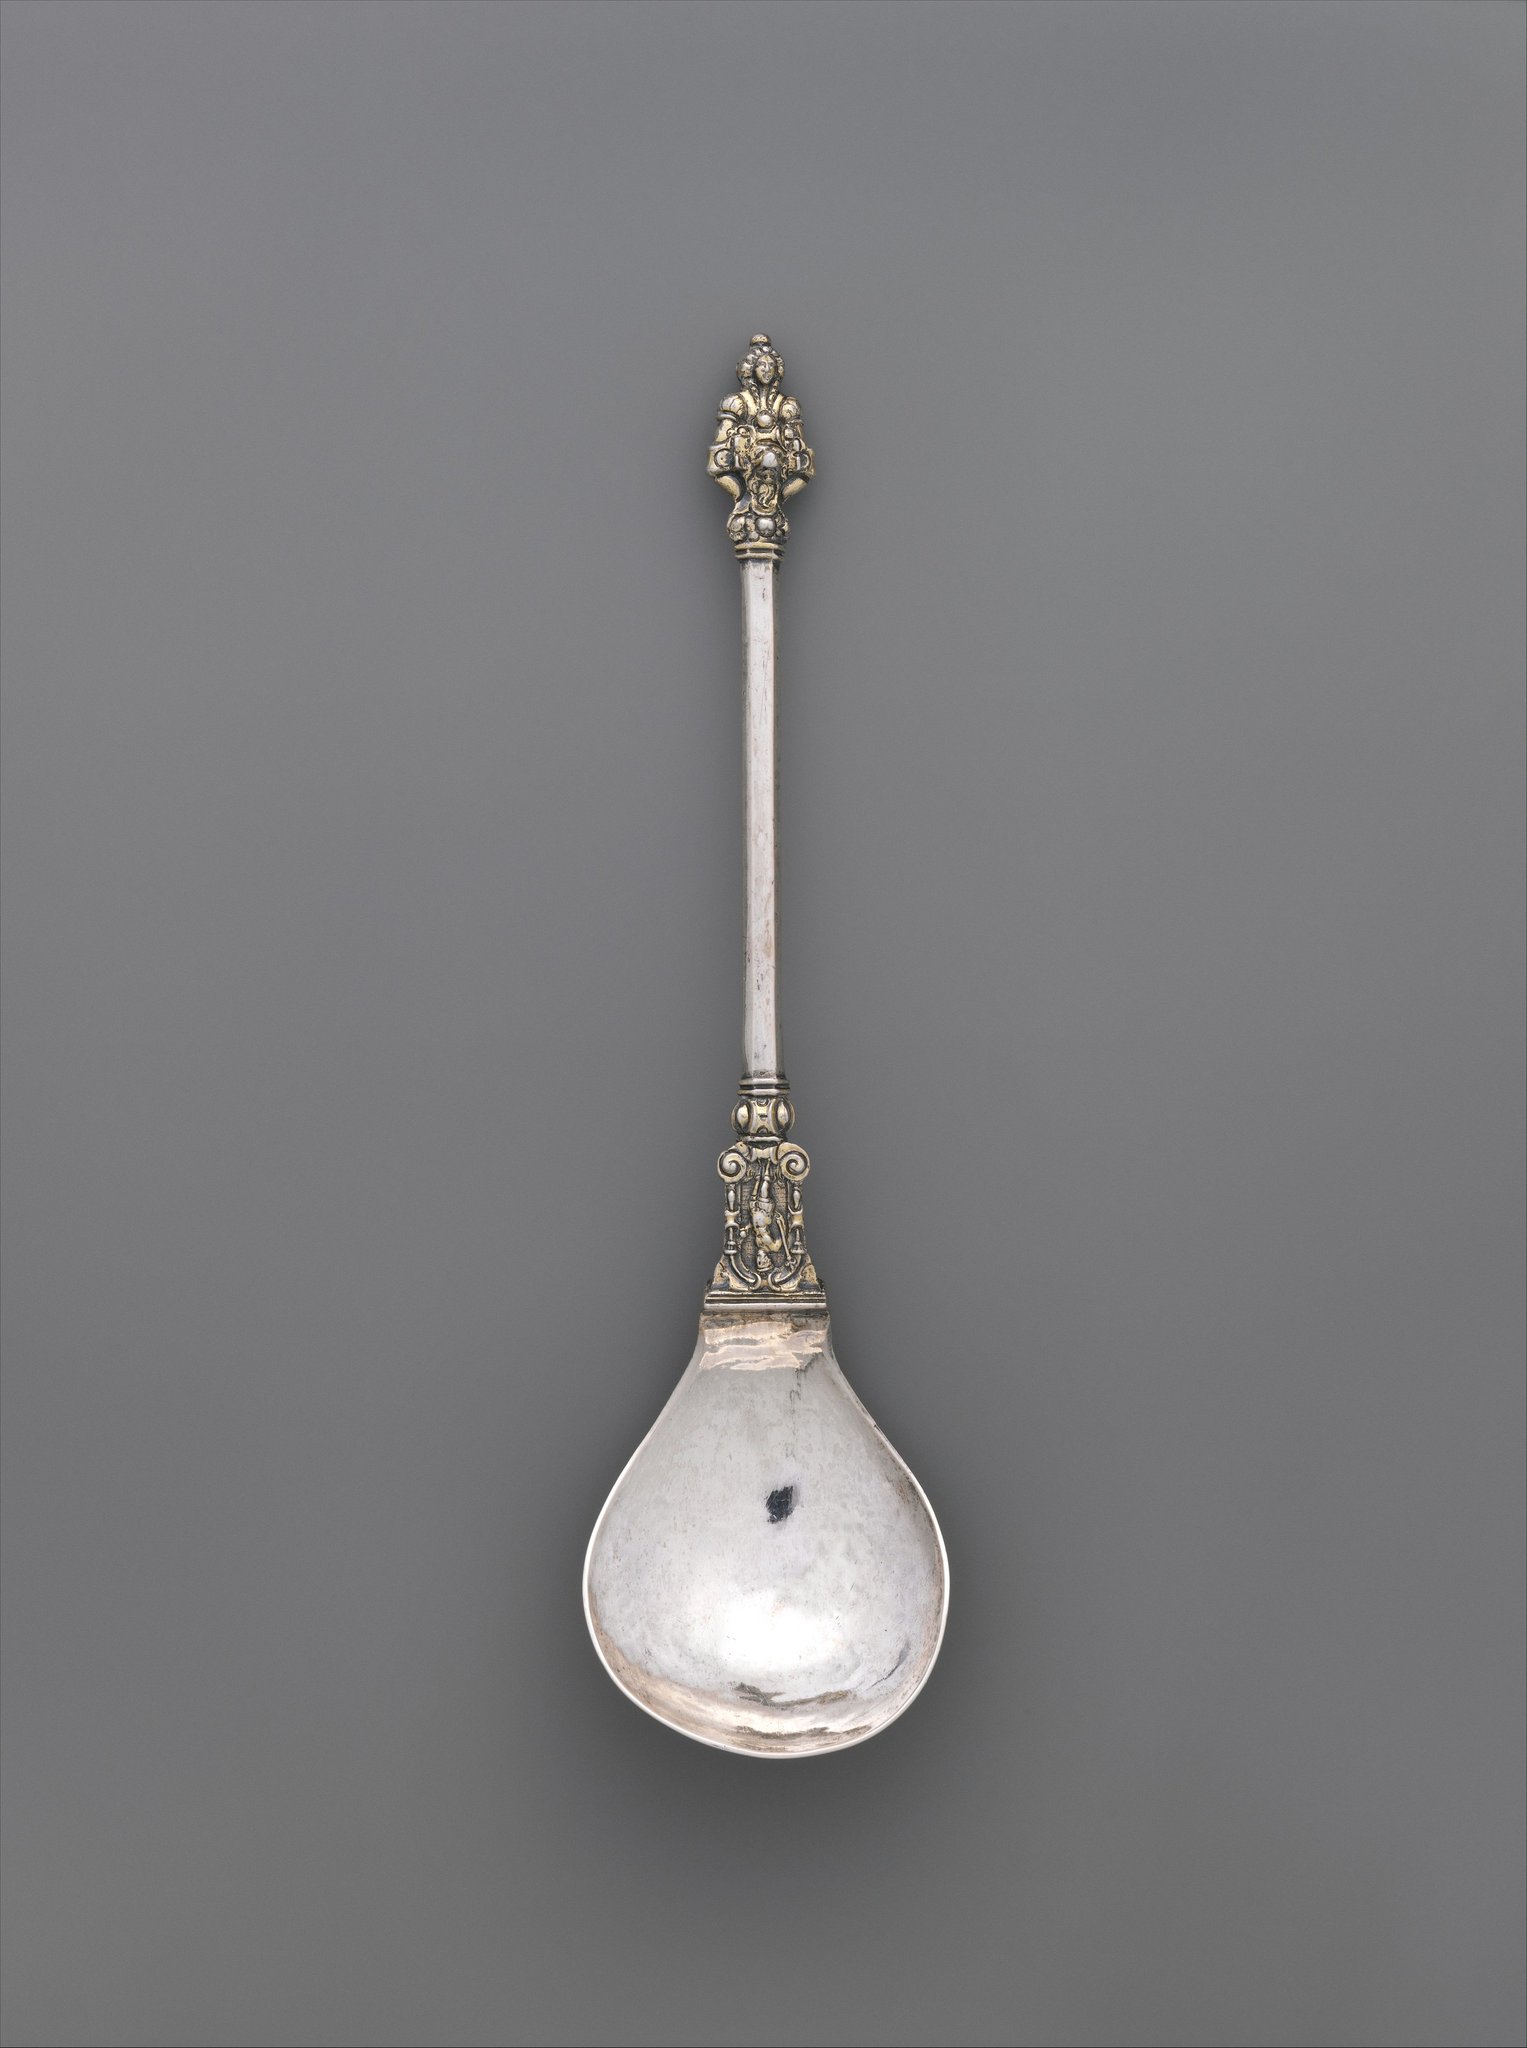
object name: spoon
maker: sebastianus aurifaber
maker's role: maker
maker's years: 1545-1605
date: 1586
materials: silver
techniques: gilding